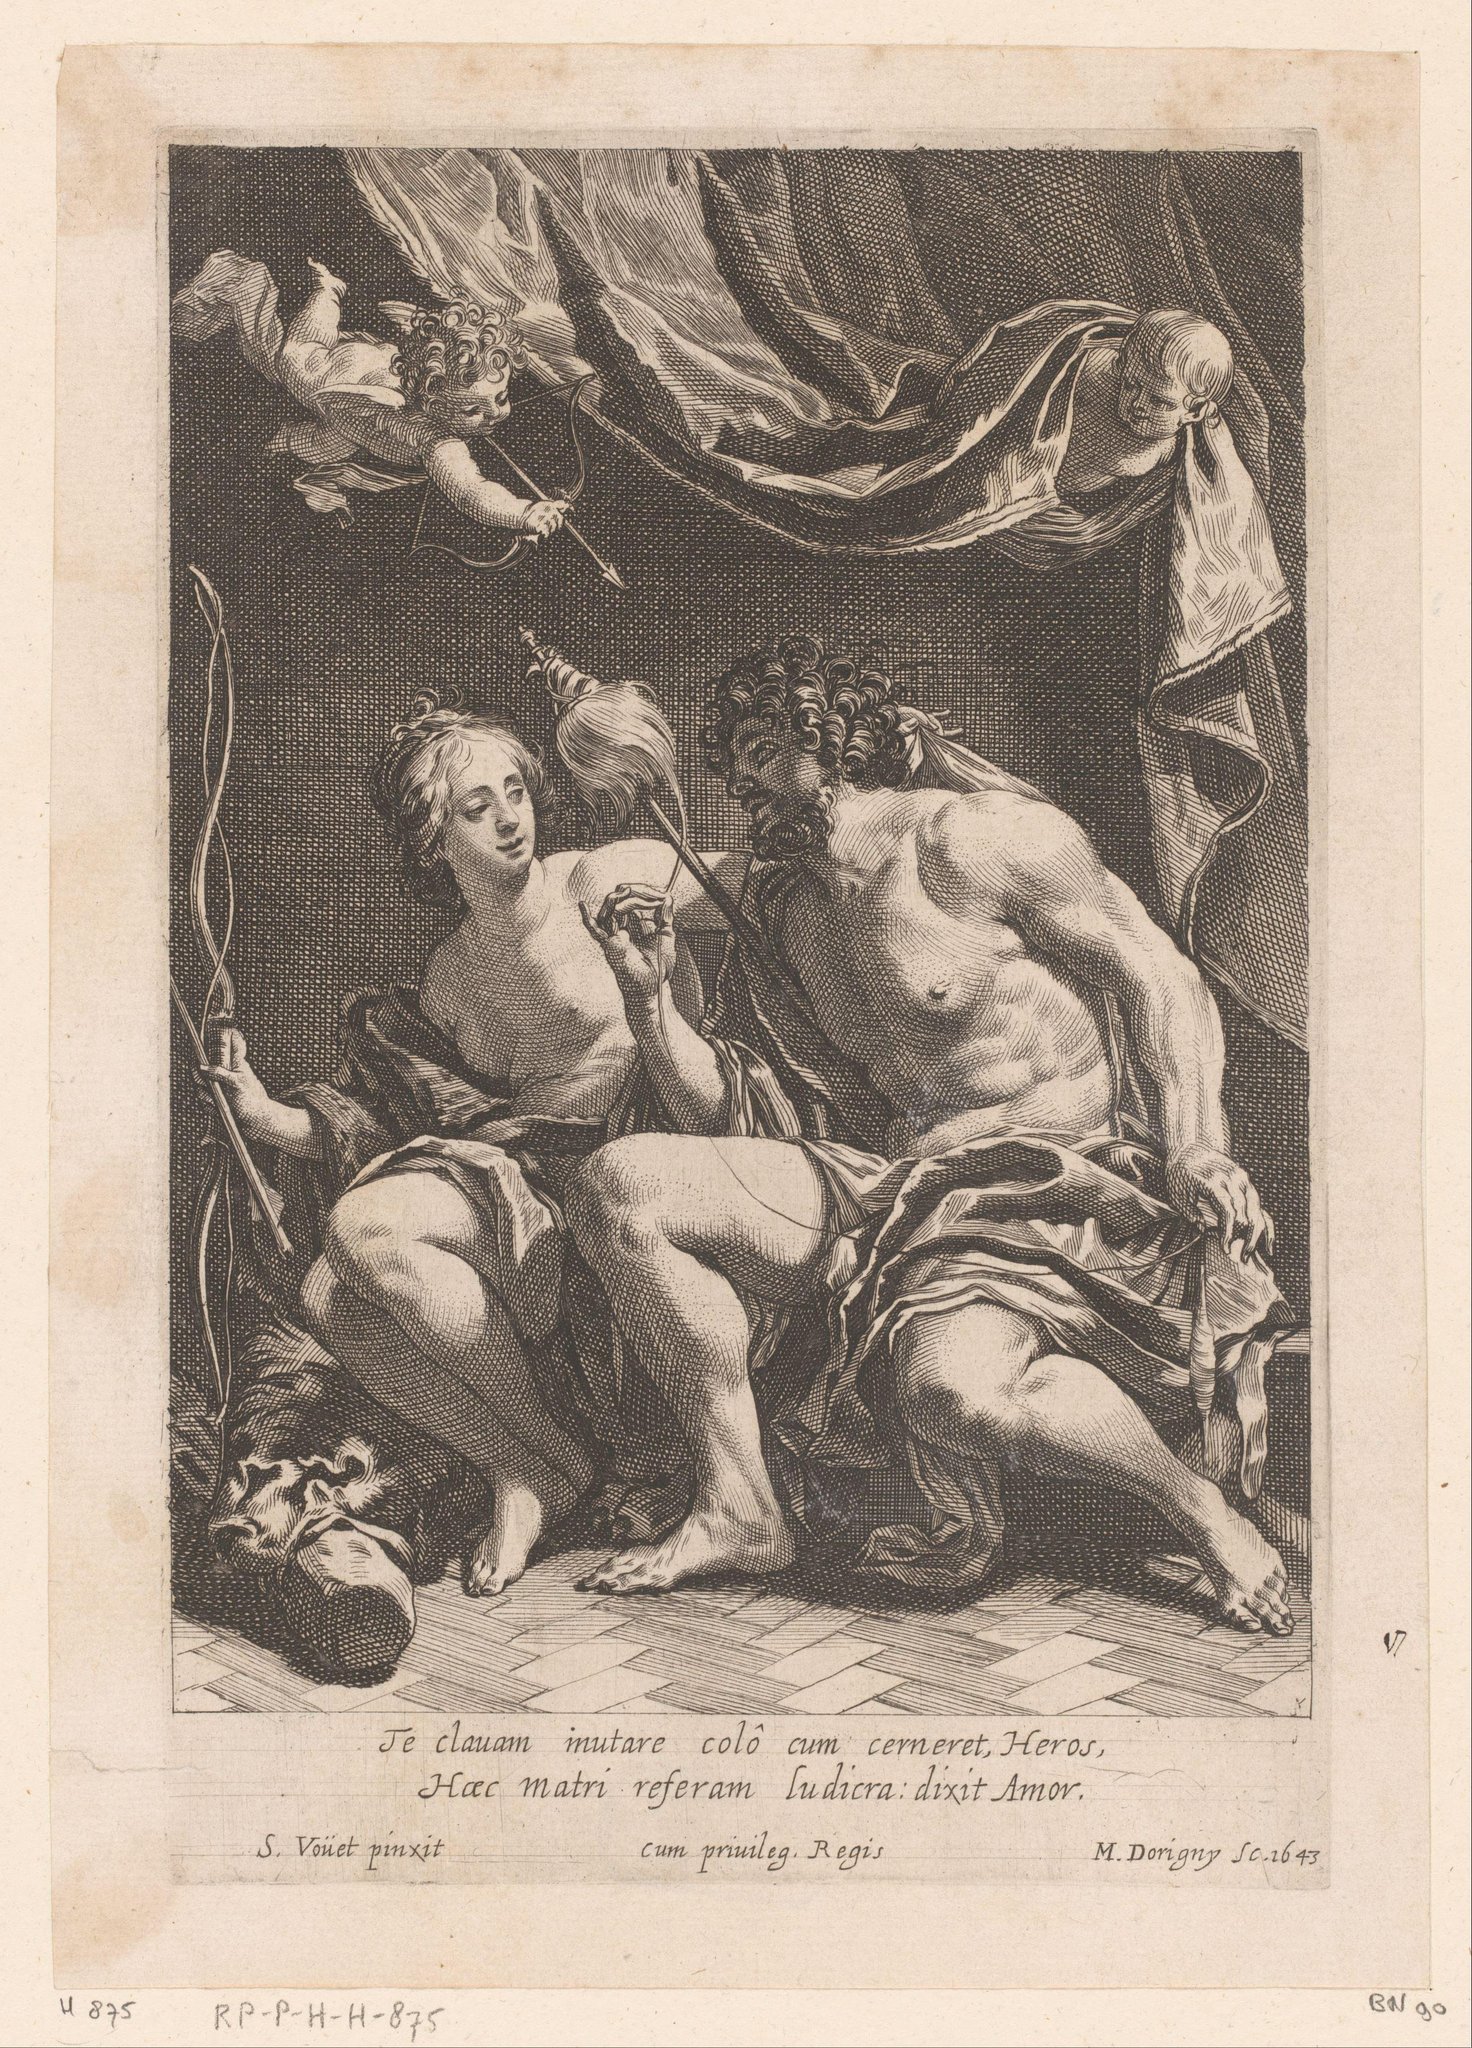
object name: print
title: Hercules en Omphale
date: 1643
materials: paper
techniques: engraving, etching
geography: france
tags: hercules in love with omphale; the hero is set to spin wool or to do other women's work among the servants, while omphale wears his lion's skin and wields his club and bow, (story of) cupid, amor (eros)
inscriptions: collector's mark: Lugt 11